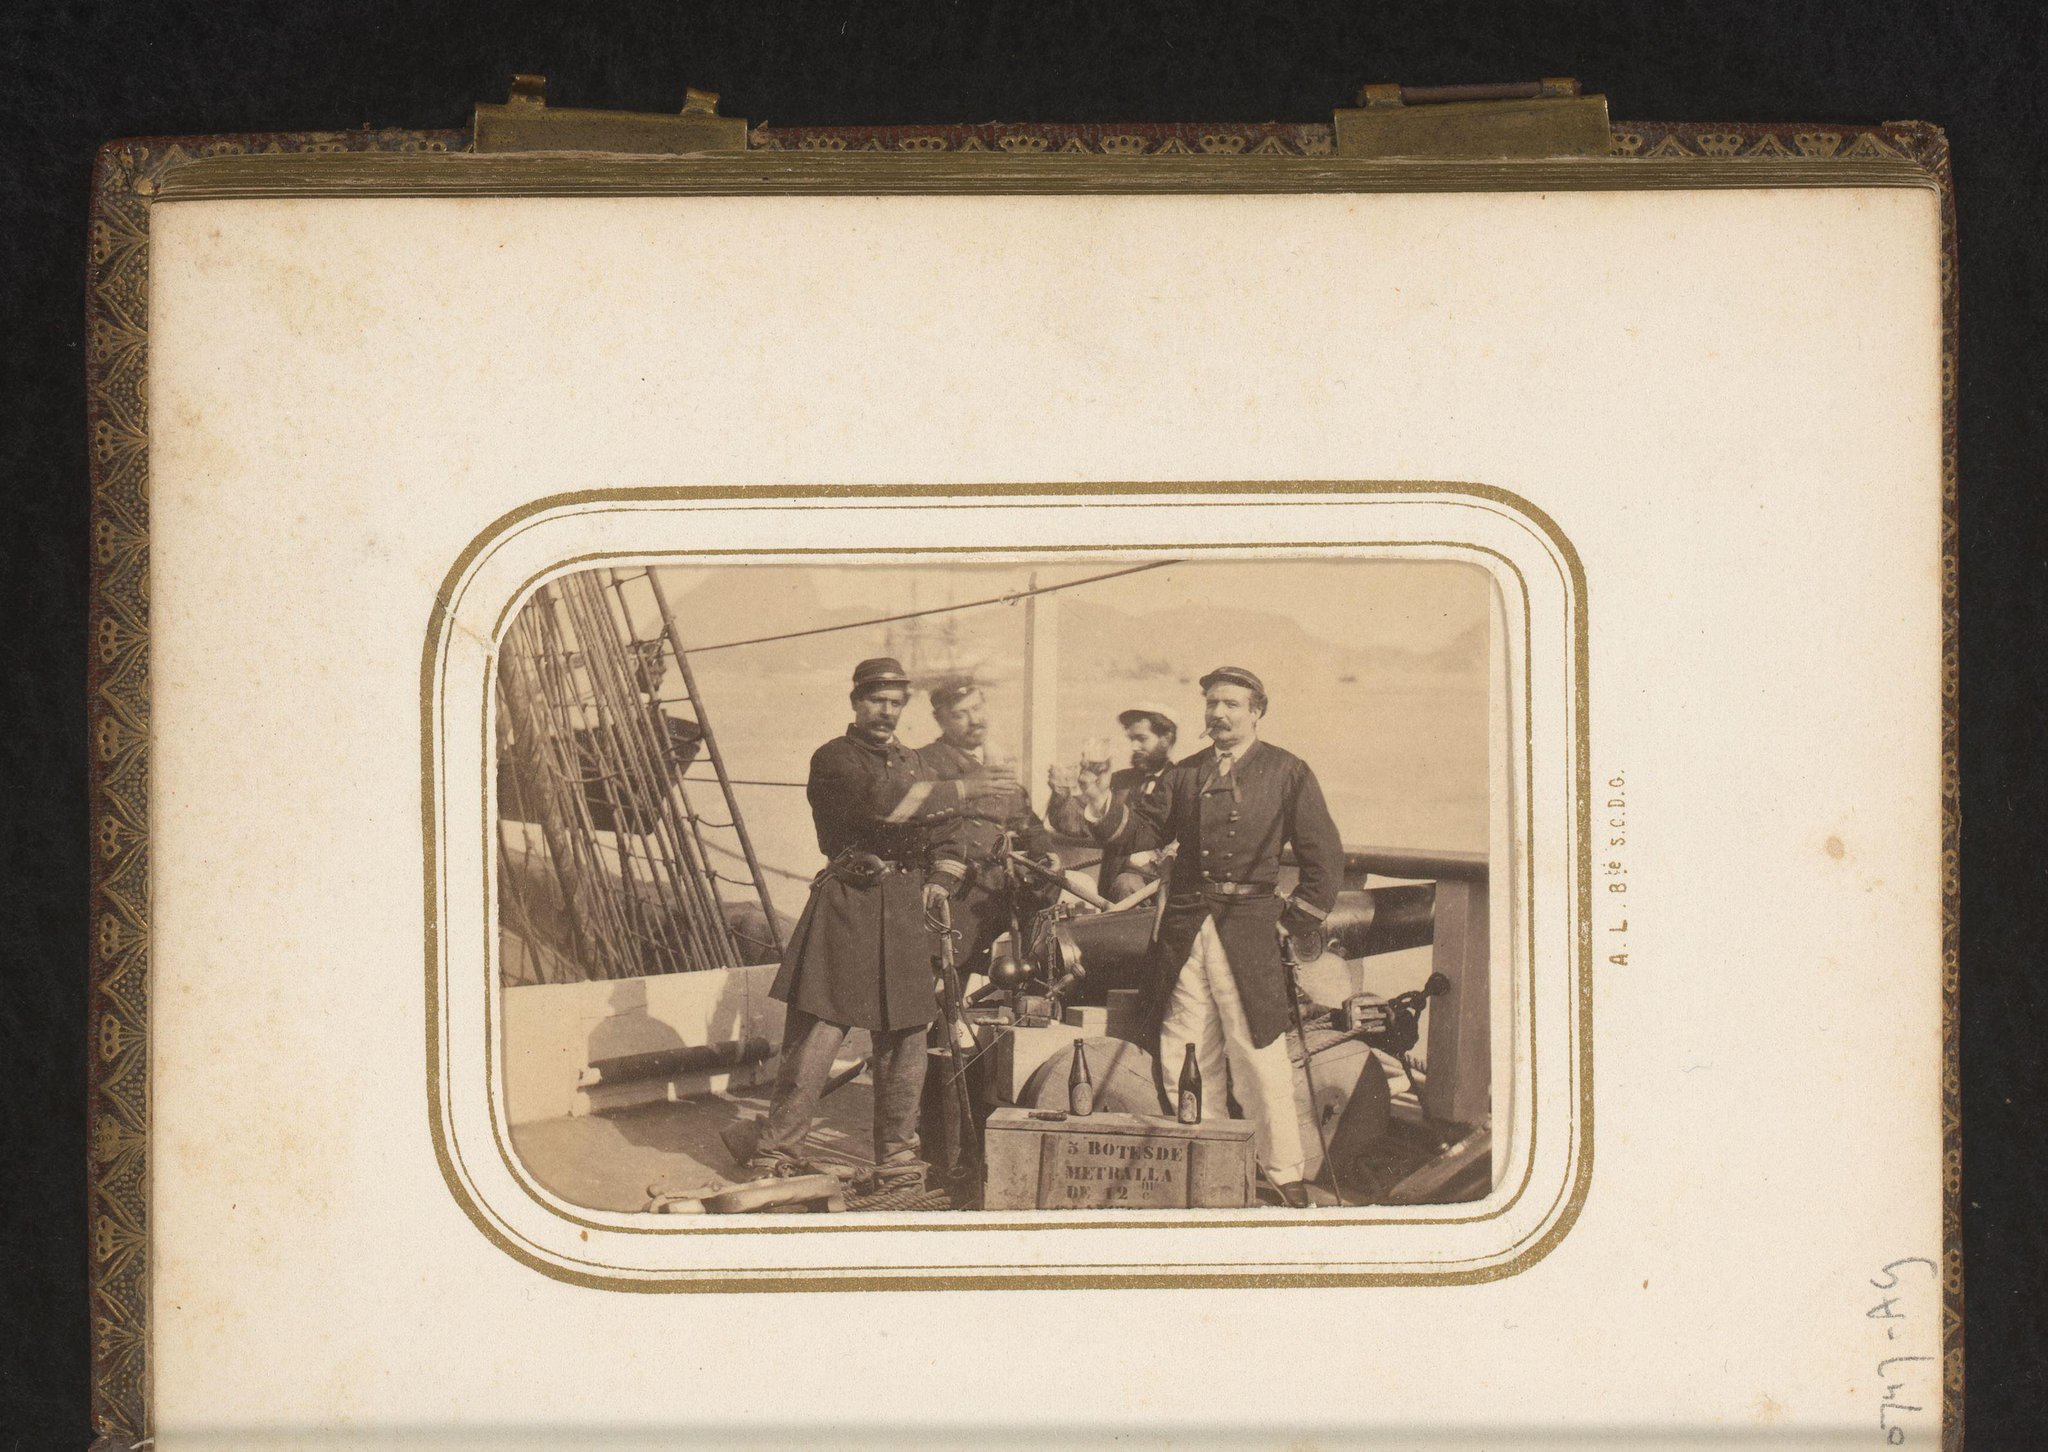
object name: album leaf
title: Bemanningsleden aan boord van een schip, het glas heffend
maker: paulo robin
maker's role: fotograaf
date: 1860-1890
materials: cardboard, photographic support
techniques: albumen print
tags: crew ~ ship, drinking, anonymous historical persons portrayed in a group, in a group-portrait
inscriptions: name: ‘Paulo Robin’, inscription: ‘Photographia/Brazileira/ 96 Rua de S. José, 96/ (Antiga do Parto)/ Rio de Janeiro’, inscription: ‘A.L. B.te S.C.D.G.’